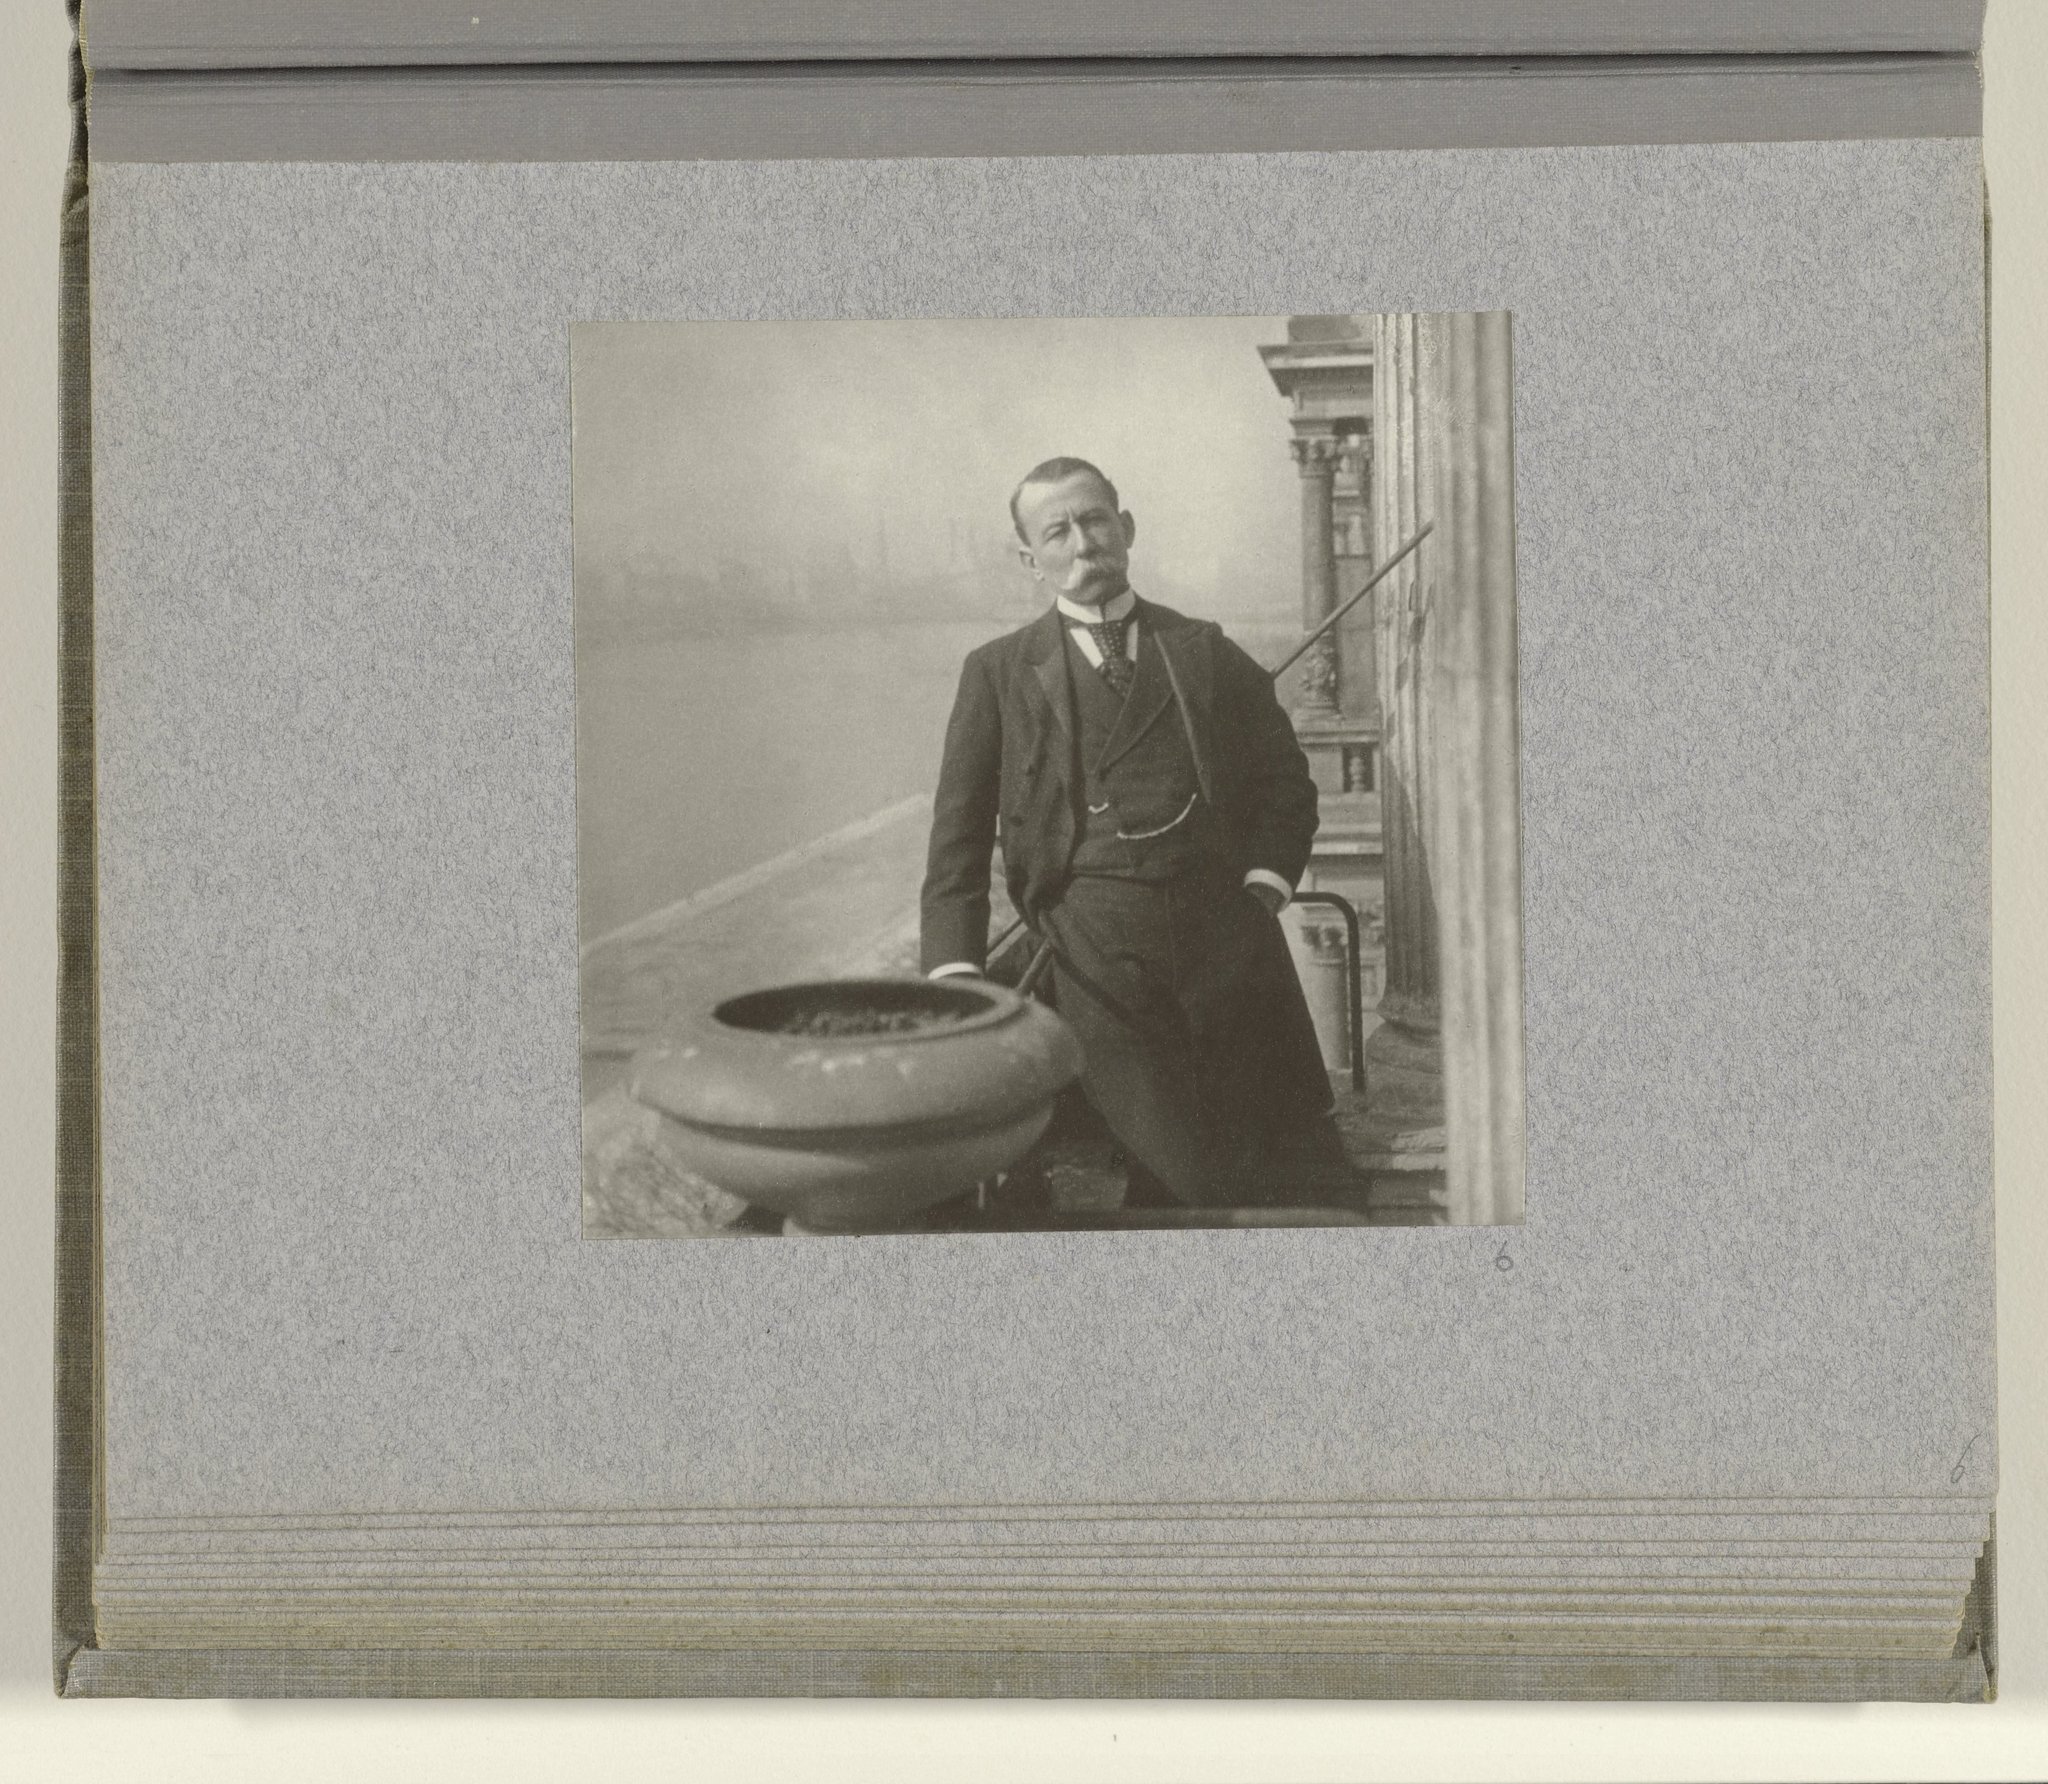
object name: photograph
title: J.B. Aug. Kessler op het balkon van zijn hotelkamer in Bonn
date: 1898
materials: paper, photographic support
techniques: gelatin silver print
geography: bonn